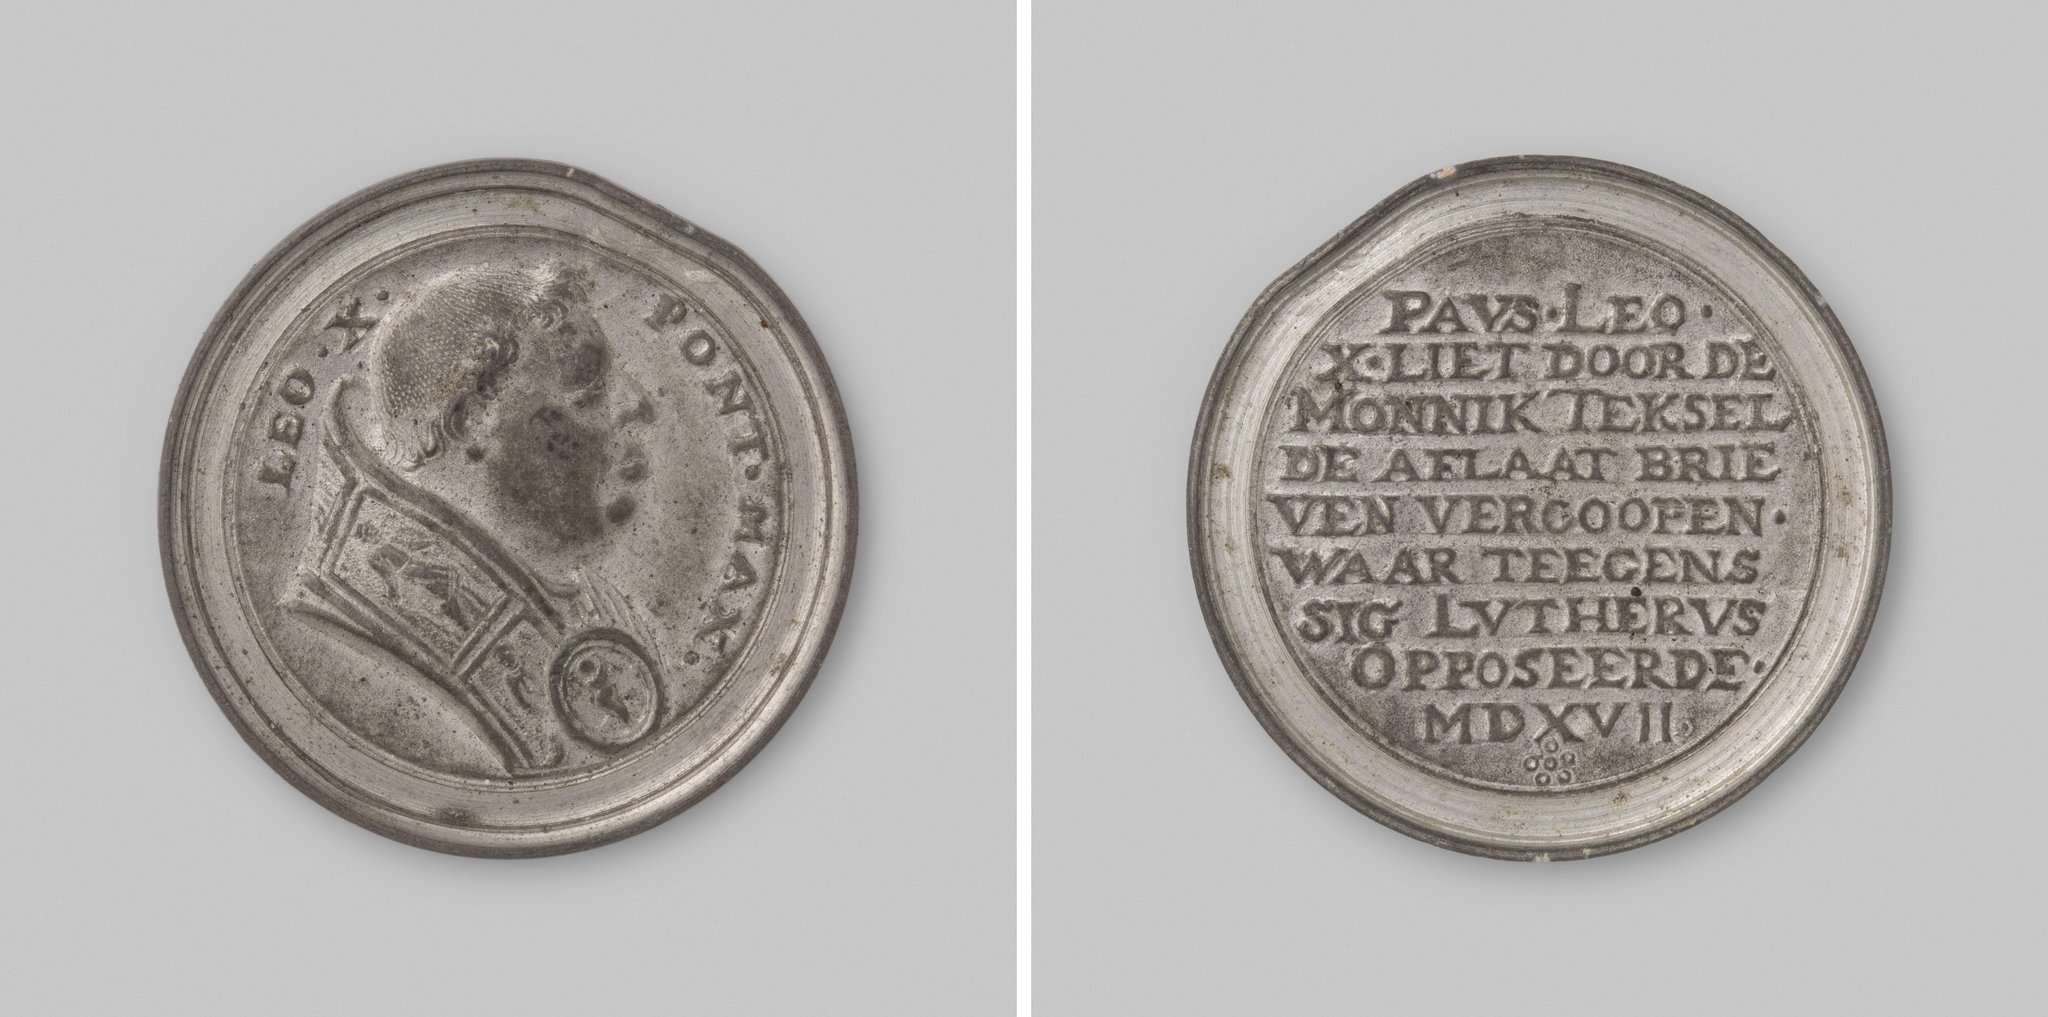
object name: history medal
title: Verzet van Martin Luther tegen de verkoop van aflaatbrieven door de monnik Tetzel op last van paus Leo X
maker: Anonymous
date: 1517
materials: lead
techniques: casting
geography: low countries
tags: leo x, priest, martin luther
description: Loden penning. Voorzijde: borststuk man binnen omschrift. Keerzijde: opschrift